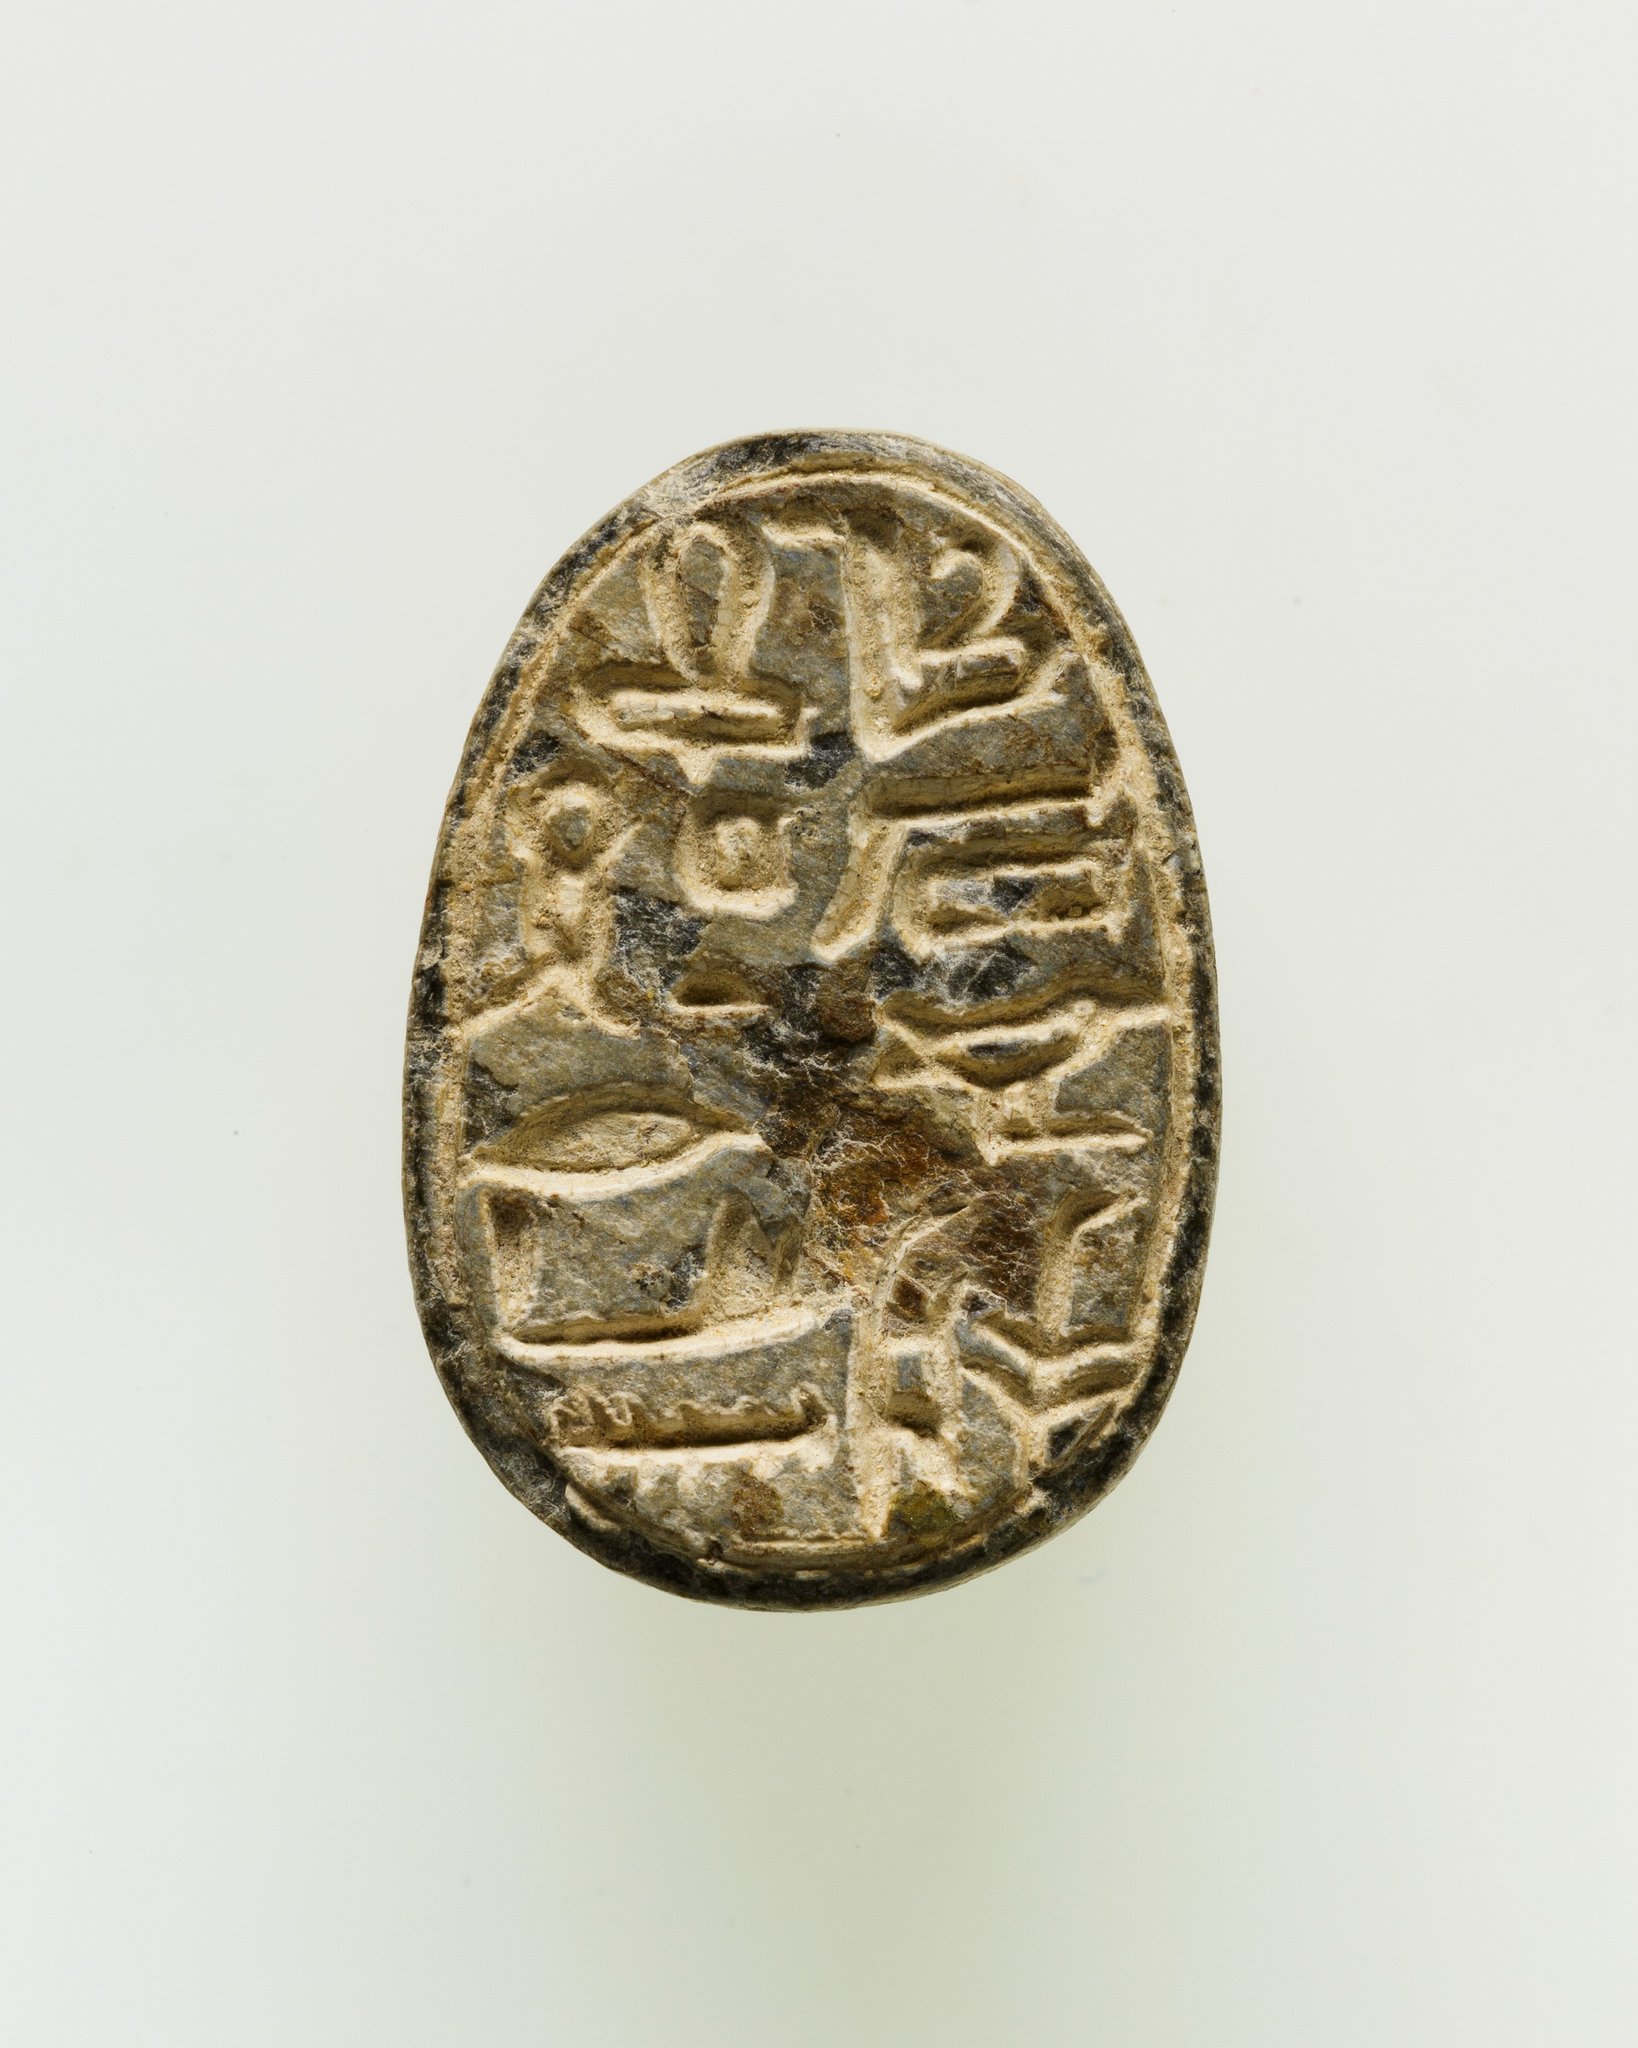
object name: scarab, official, private name and title, redenptah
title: Scarab of an Official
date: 1750-1640 BCE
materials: stone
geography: egypt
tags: scarabs